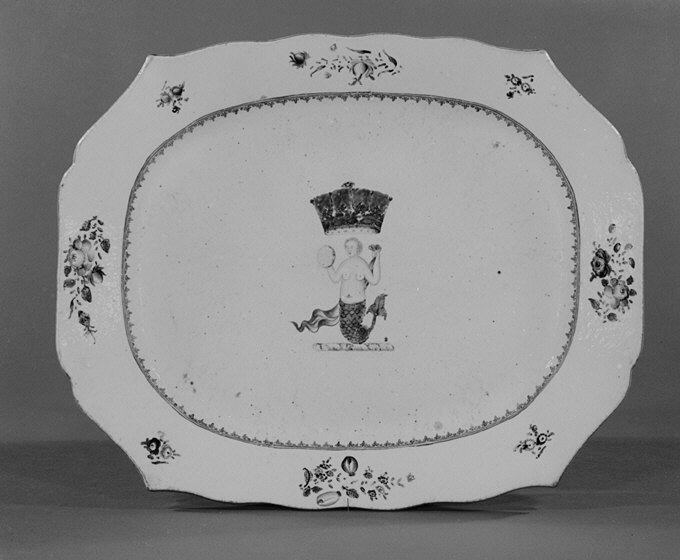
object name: platter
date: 1760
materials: hard paste porcelain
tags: mermaids